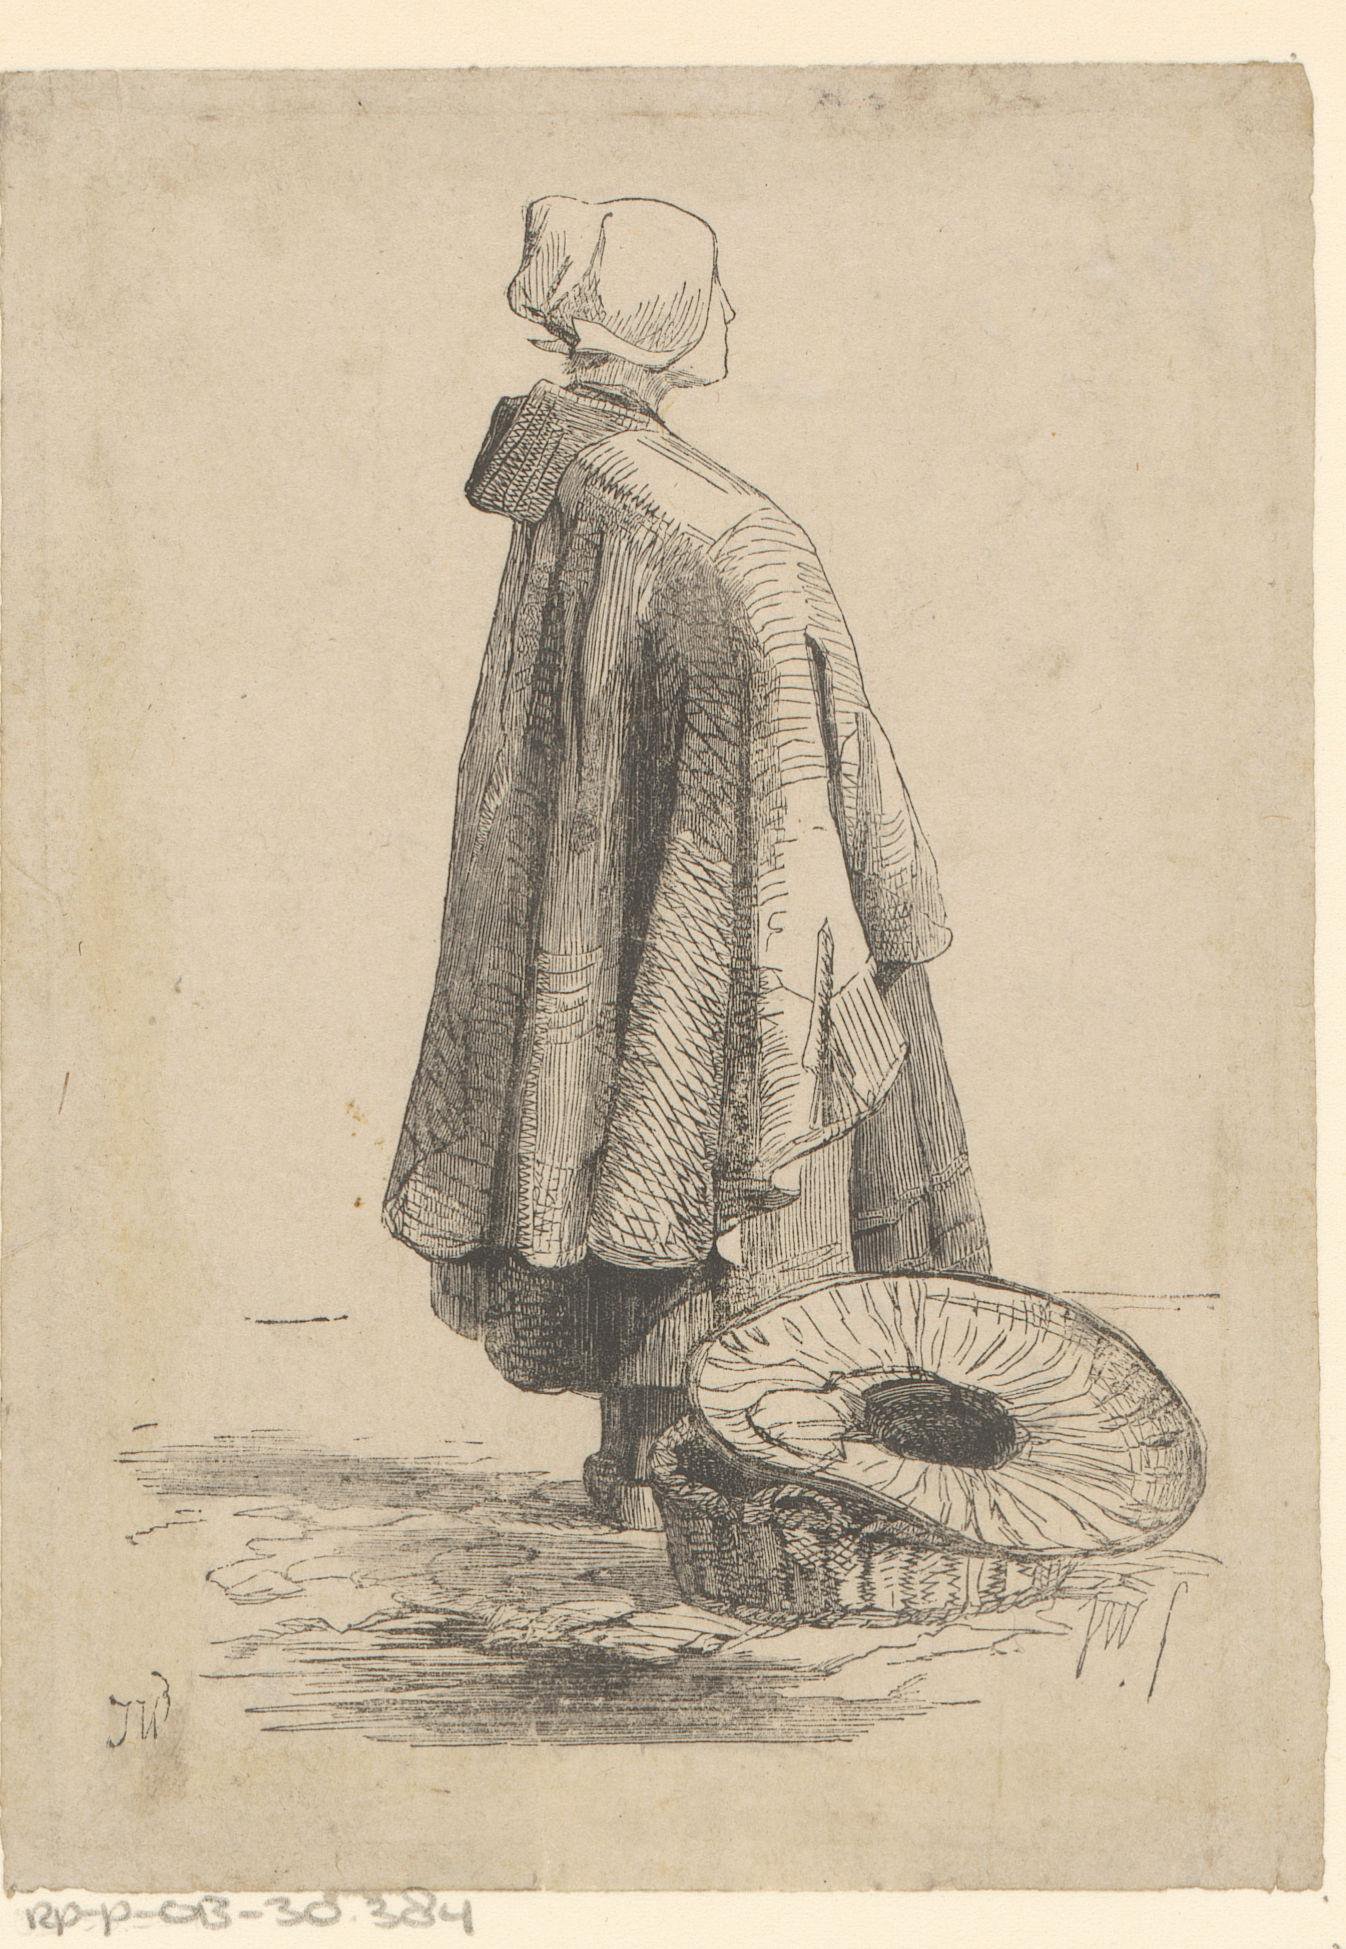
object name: print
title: Vrouw met een cape staand naast een rieten mand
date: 1836-1912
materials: paper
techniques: engraving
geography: netherlands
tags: cape (+ women's clothes), container made of plant material other than wood: basket